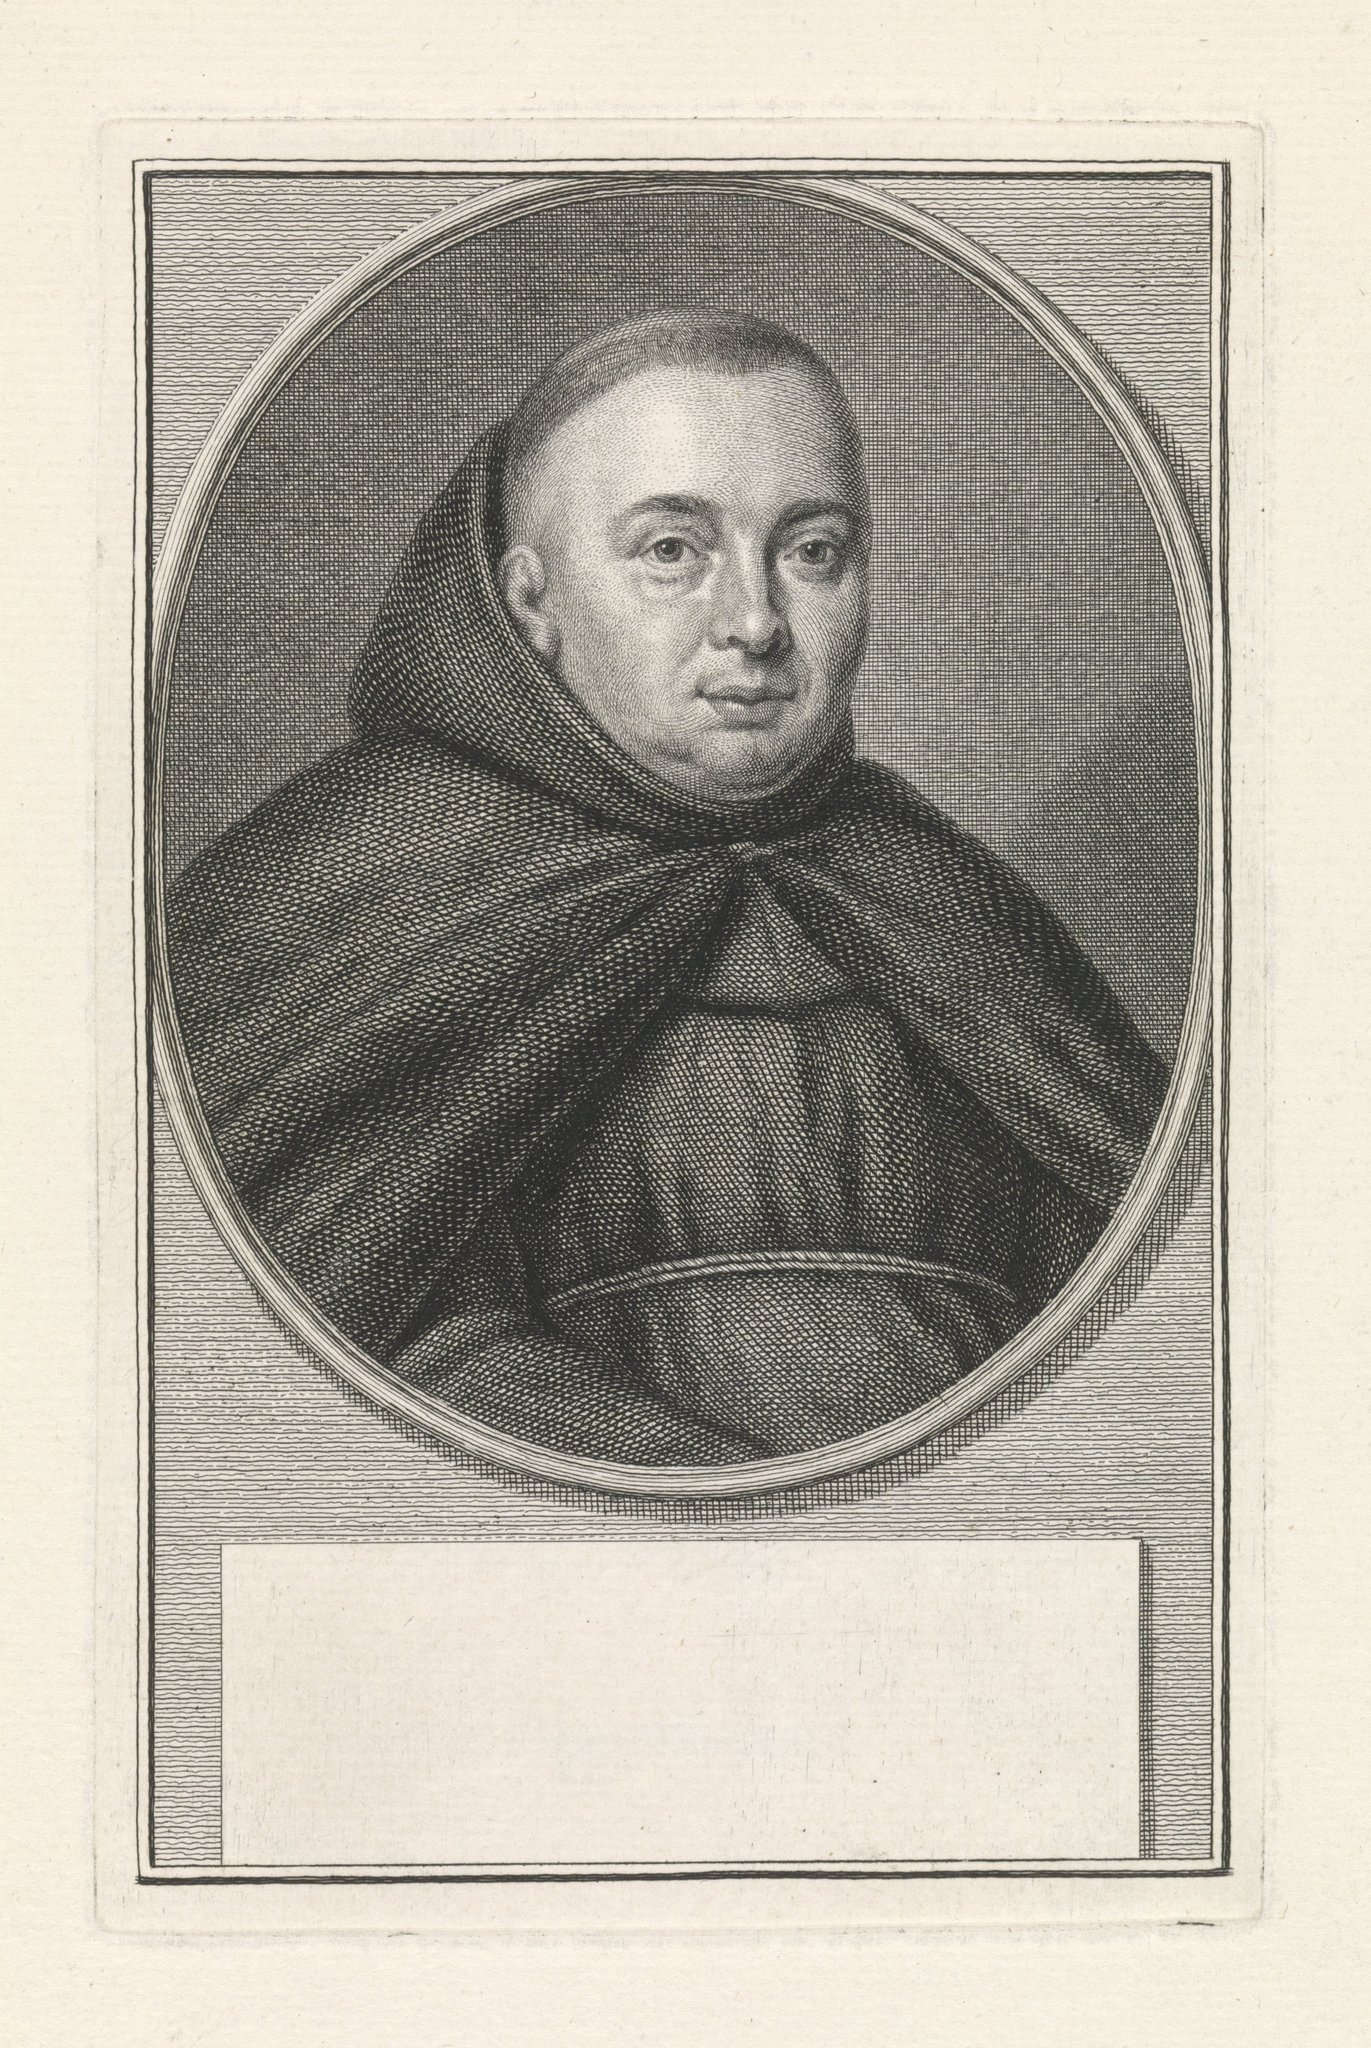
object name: print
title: Portret van Willem Smits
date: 1716-1761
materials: paper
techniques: engraving, etching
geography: amsterdam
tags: monk(s), friar(s)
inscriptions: collector's mark: Lugt 240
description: Portret van Willem Smits, monnik van de orde van de Recolletten en bijbeluitlegger.